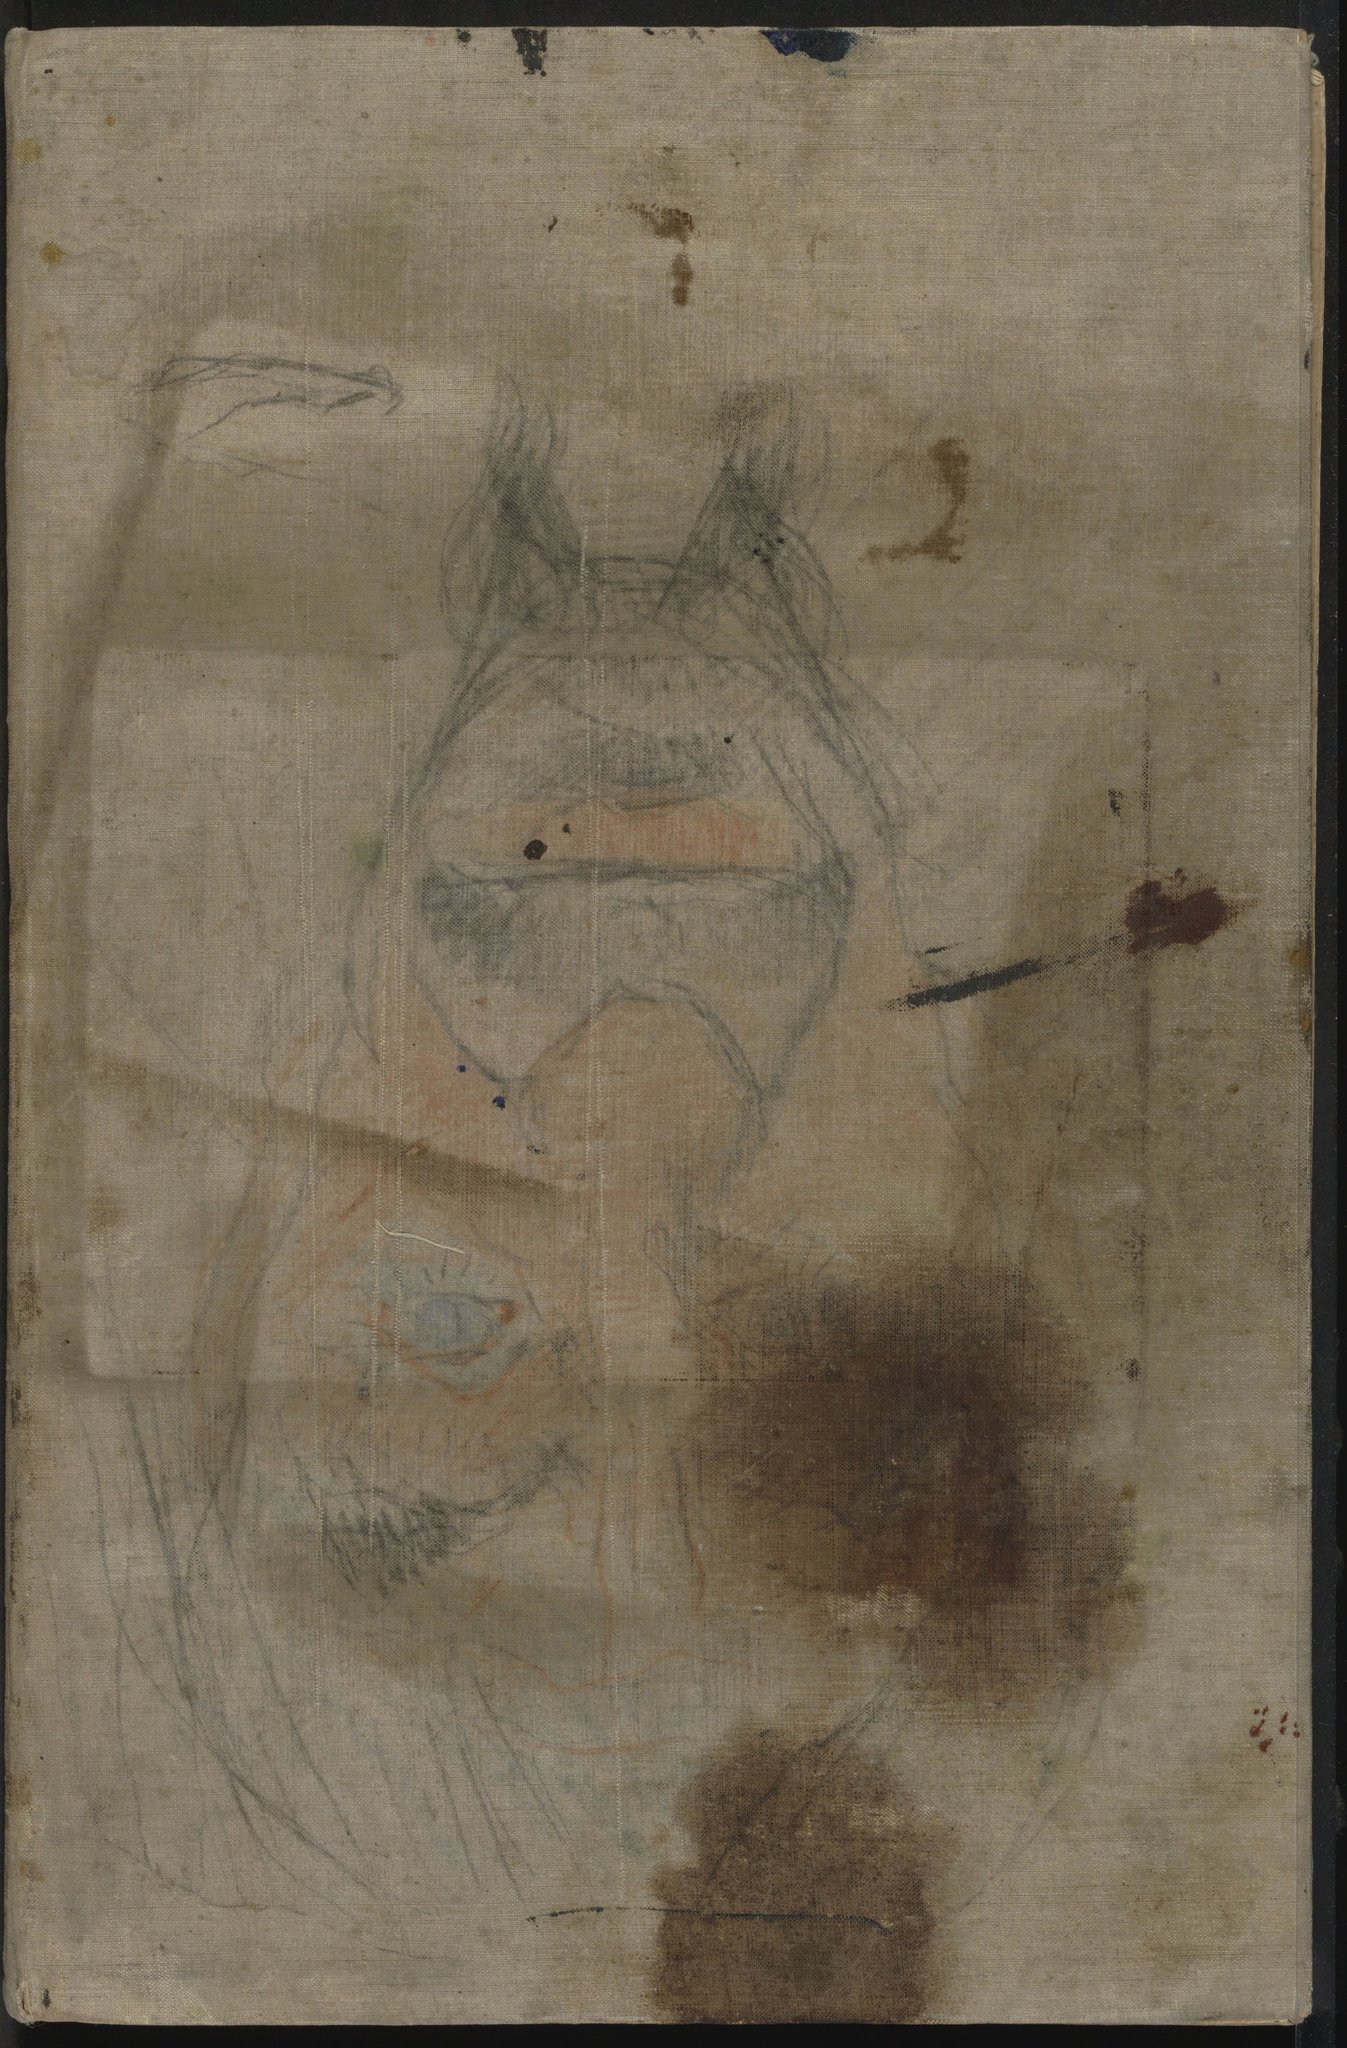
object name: sketchbook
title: Schetsboek met 45 bladen vervaardigd rond de Ewijkshoeve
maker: willem witsen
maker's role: draughtsman, painter, print maker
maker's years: 1860-1923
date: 1884-1887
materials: cardboard, chalk, linen, paper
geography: maartensdijk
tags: cattle driving, cattle driver, sheep, stall, stable, herd, flock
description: Schetsboek bestaande uit 45 bladen met herders, schaapskooien, landschappen en figuurstudies vervaardigd rond de Ewijkshoeve. Op de voorzijde een mannengezicht, van voren gezien, en op de achterzijde een mannenhoofd in profiel.